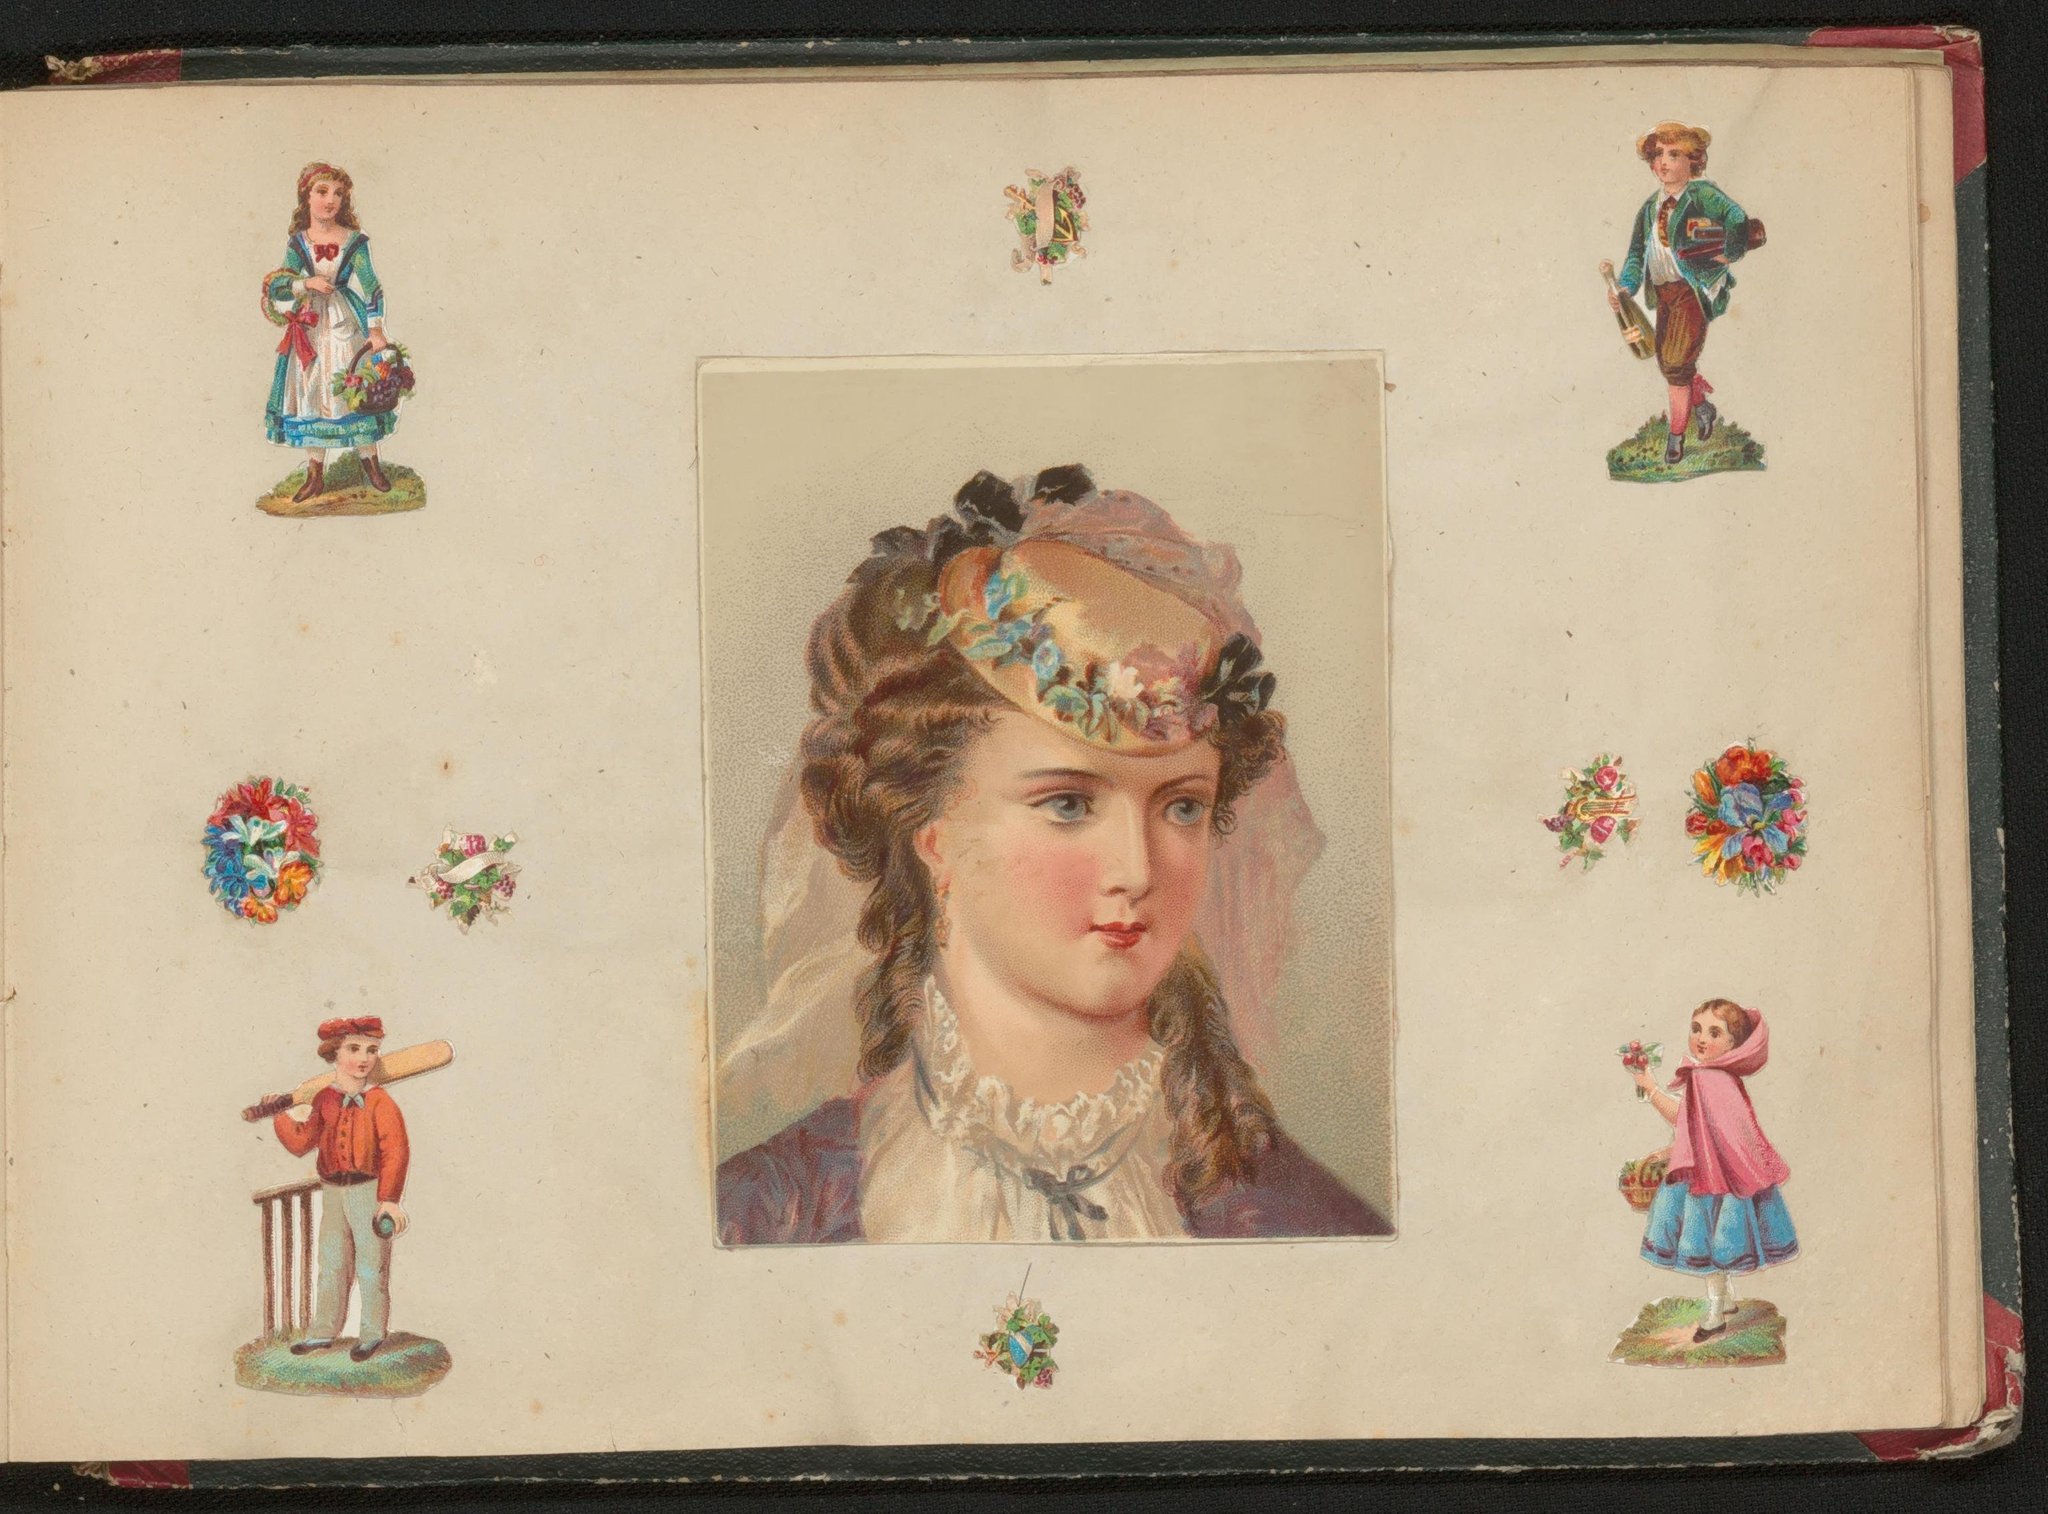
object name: album leaf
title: Albumblad met 11 plakplaatjes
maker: Anonymous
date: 1880-1910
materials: paper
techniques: chromolithography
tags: cut flowers; nosegay, bunch of flowers, children's games and plays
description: Albumblad met 11 plakplaatjes van boeketten en kinderen, centraal een buste van een elegante dame. Onderdeel van het plakboek met 38 bladen gevuld met plakplaatjes, poesieplaatjes en uitgeknipte en ingeplakte fragmenten van prenten. Onderwerpsrubrieken binnen de Atlas Zeden en Gewoonten: Schoone kunsten, Varia.